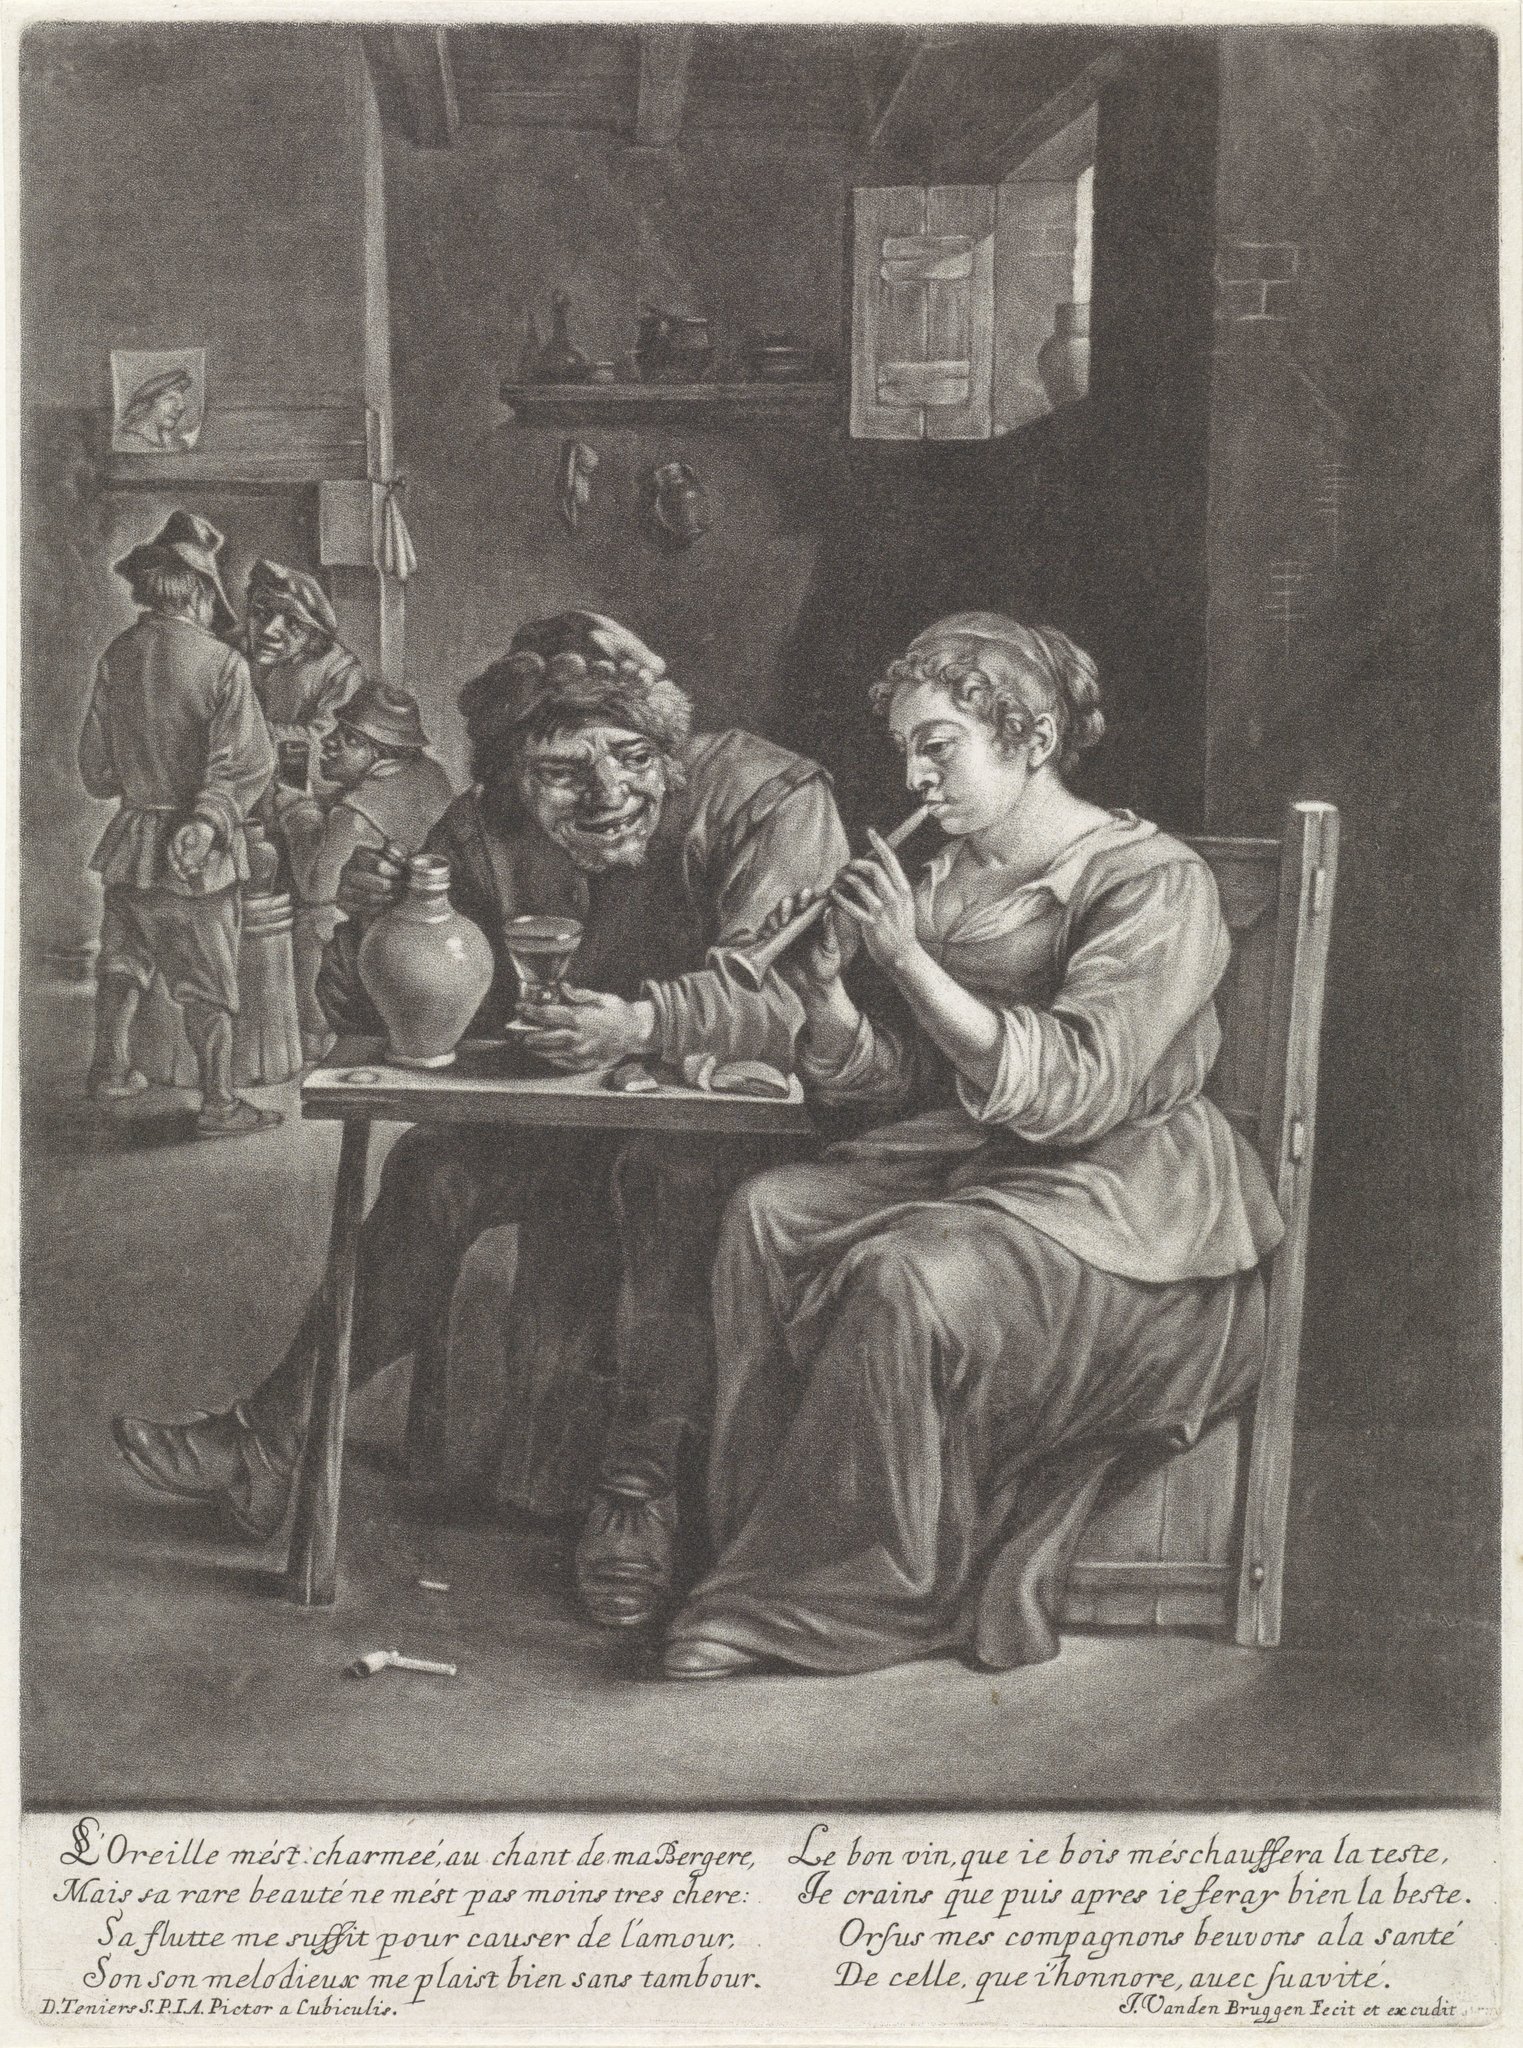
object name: print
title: Herberg met een fluitspelende vrouw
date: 1659-1693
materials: paper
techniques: engraving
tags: one person playing wind instrument, print, e.g.: engraving, etching, lithograph, pipe ~ tobacco, hotel, hostelry, inn, flute, aulos, tibia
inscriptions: collector's mark: Lugt 2228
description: In een herberg zit een vrouw naast een boer aan een tafeltje fluit te spelen. Op de achtergrond drie drinkende boeren bij de haard. Boven de haard hangt een prent of tekening met een buste van een man.